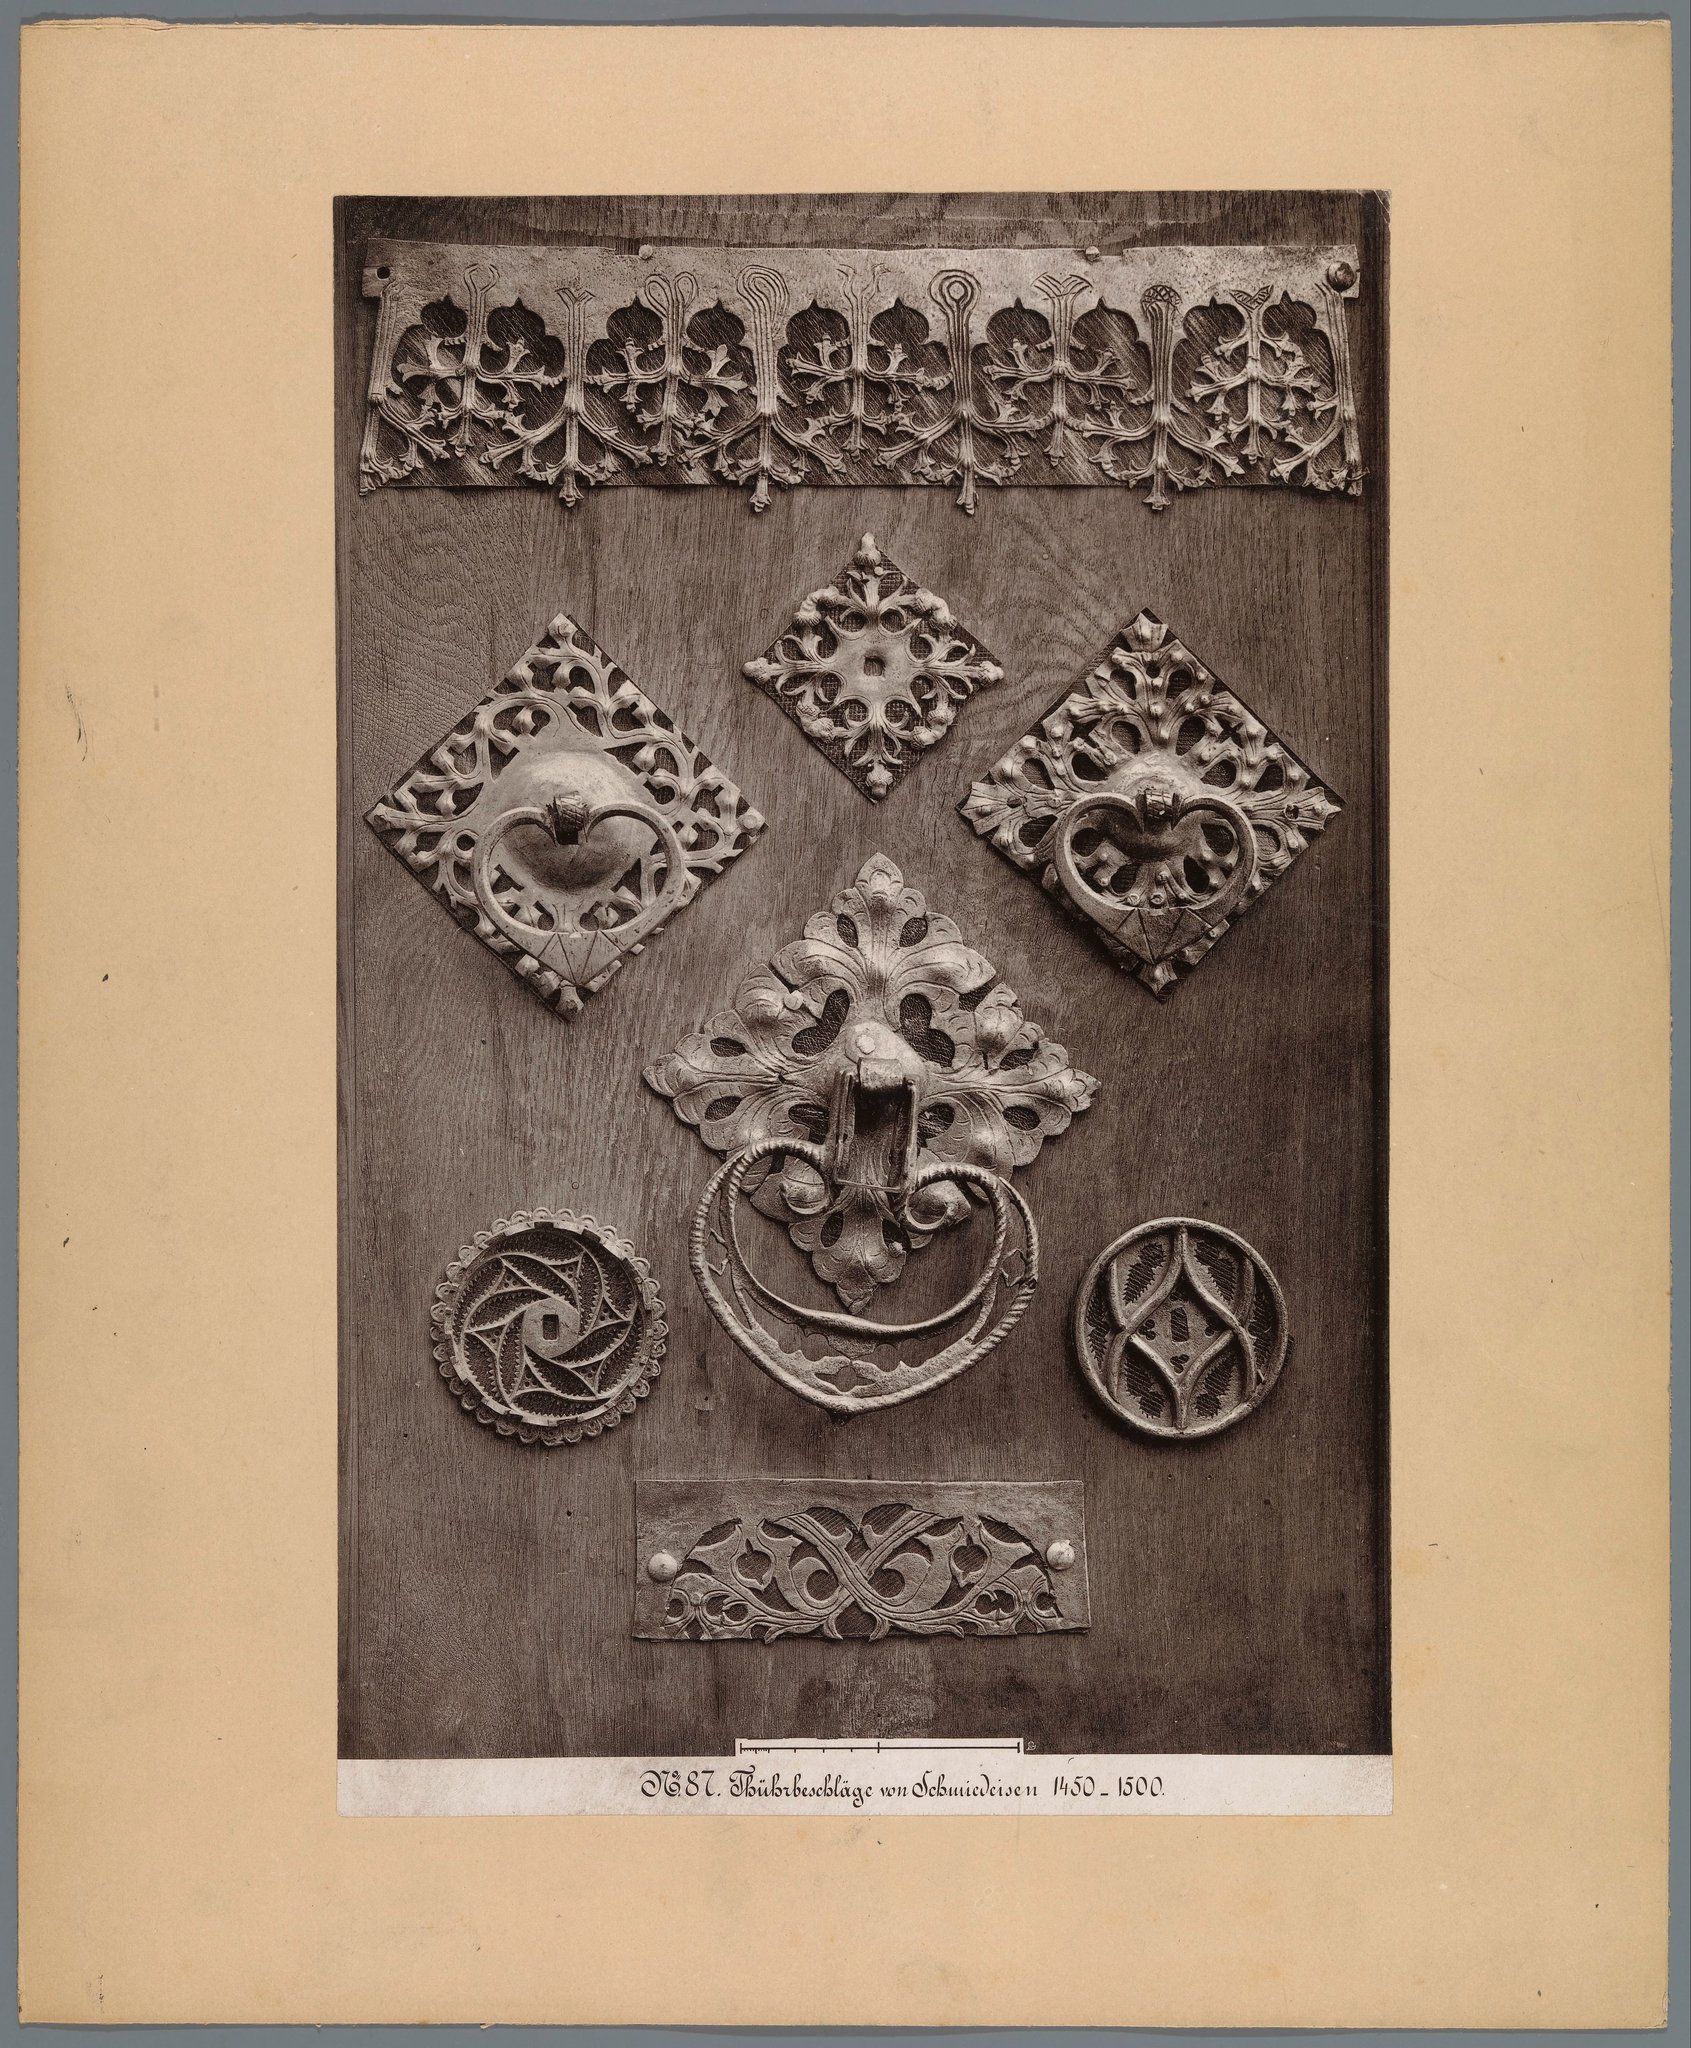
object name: photograph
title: Smeedijzeren deurbeslag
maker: Anonymous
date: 1875-1900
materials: cardboard, paper, ink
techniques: photograph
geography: germany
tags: door-knocker, doorbell, metalwork of a door, germany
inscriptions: name: ‘BAYERISCHES NATIONALMUSEUM’, collector's mark: Lugt 3937, number: ‘No. 87.’